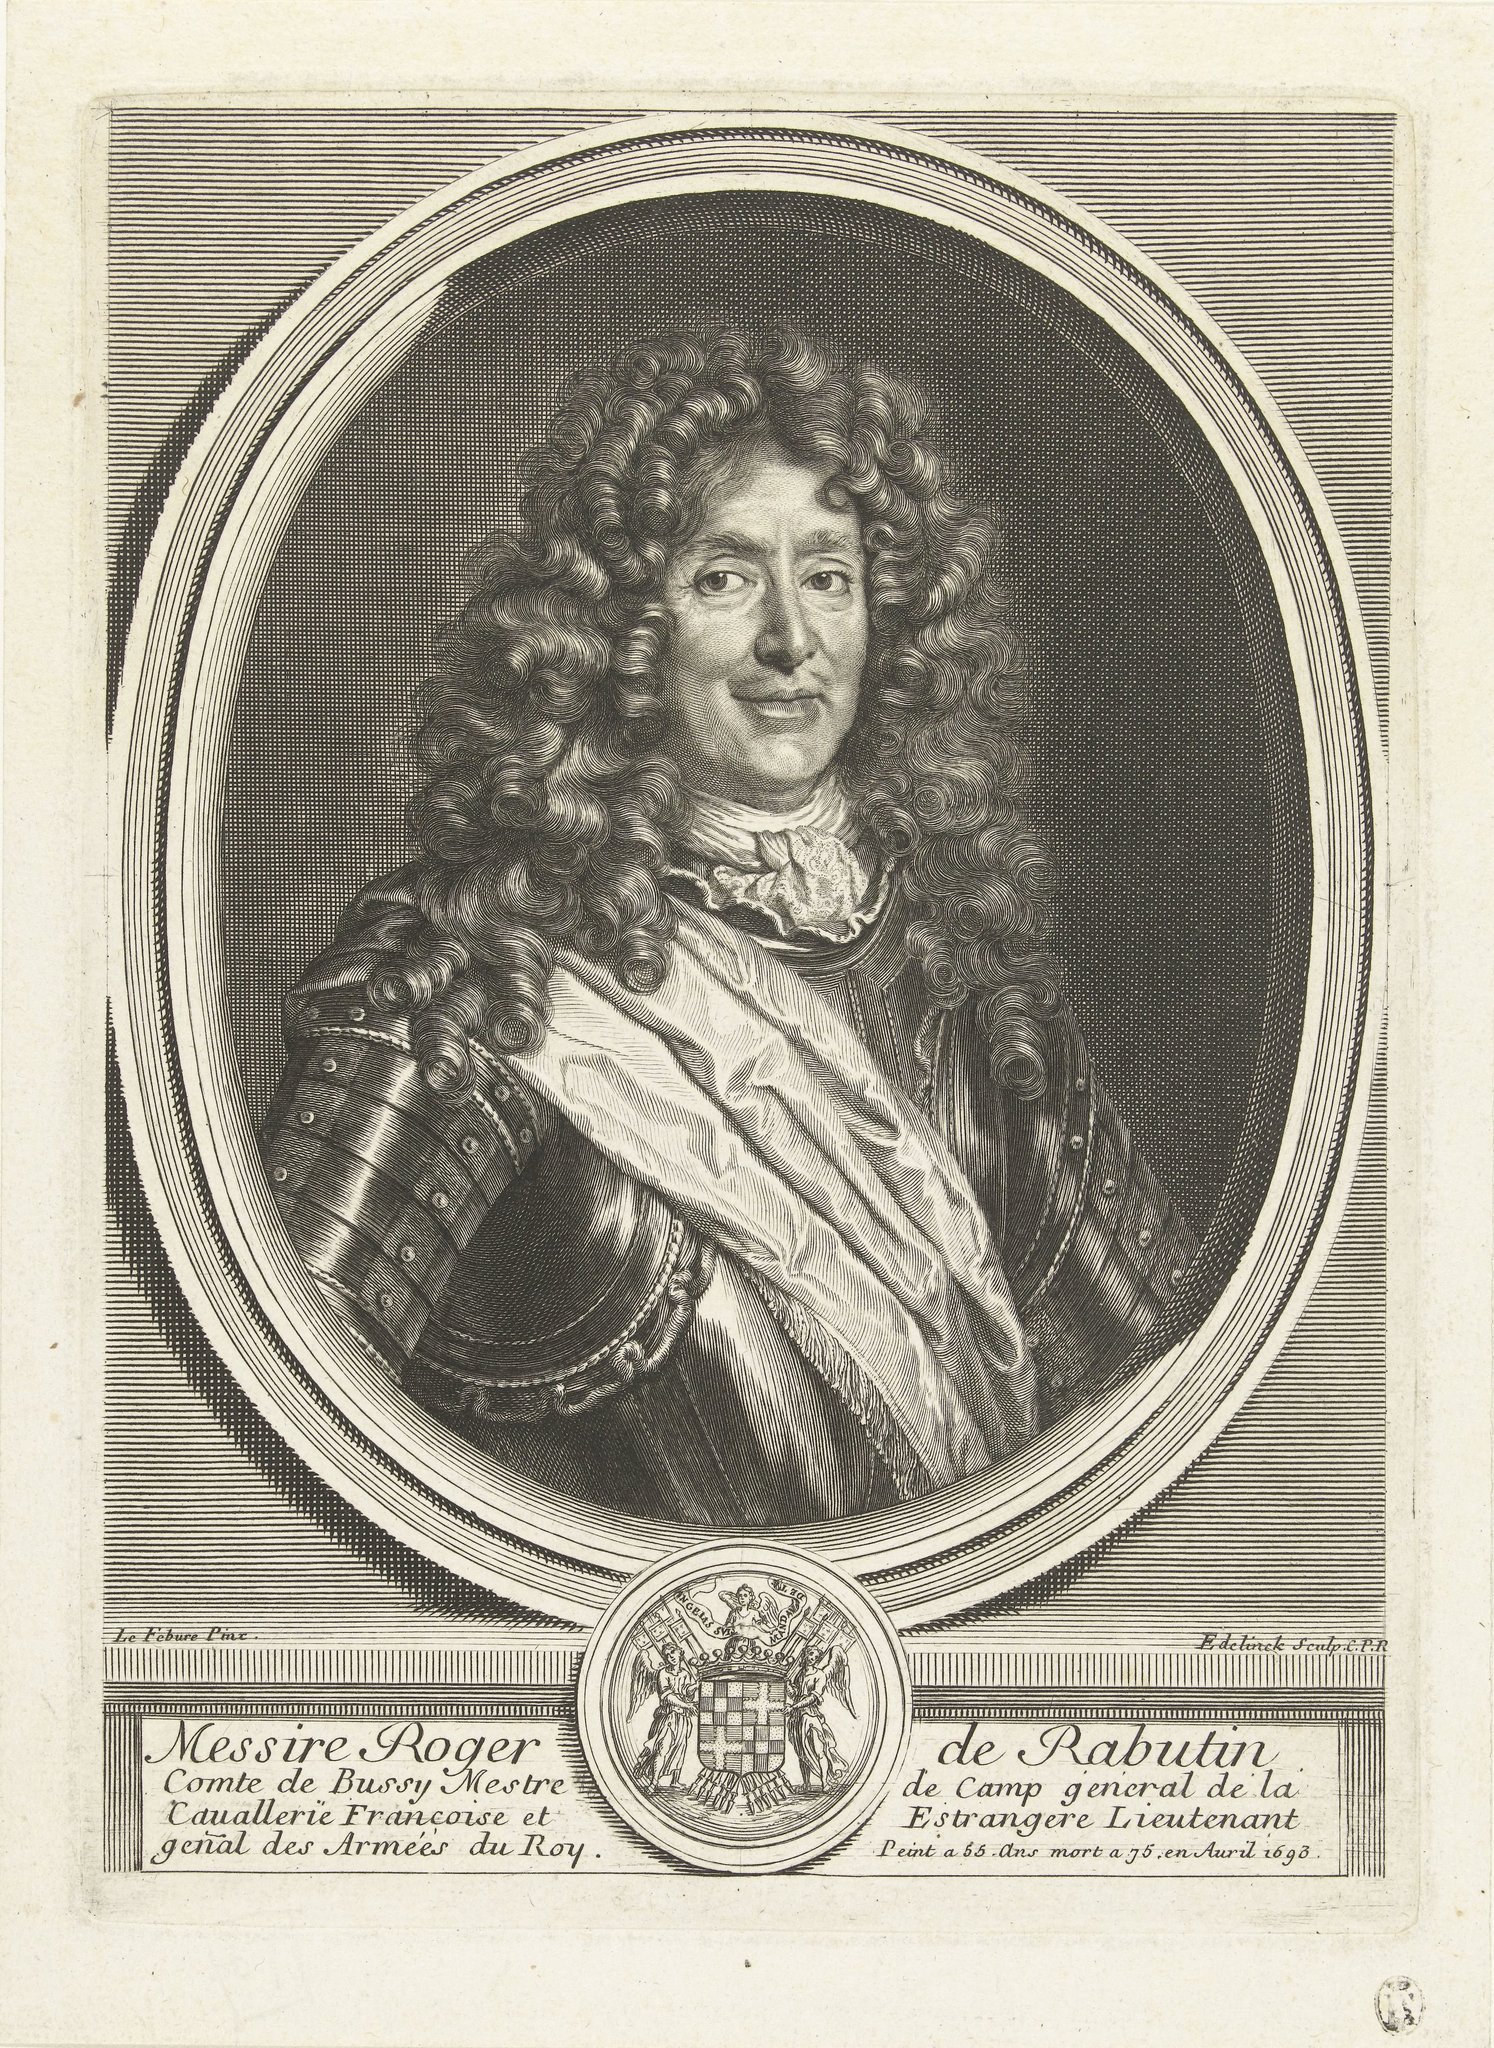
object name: print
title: Portret van Roger de Bussy-Rabutin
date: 1693-1707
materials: paper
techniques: engraving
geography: france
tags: earl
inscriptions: collector's mark: Lugt 2760, collector's mark: Lugt 2228, collector's mark: Lugt 971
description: Portret van Roger de Rabutin (1618-1693), graaf van Bussy, luitenant generaal van de koninklijke troepen. Afgebeeld in ovale omlijsting, waaronder vier regels Latijn met in het midden zijn wapen.